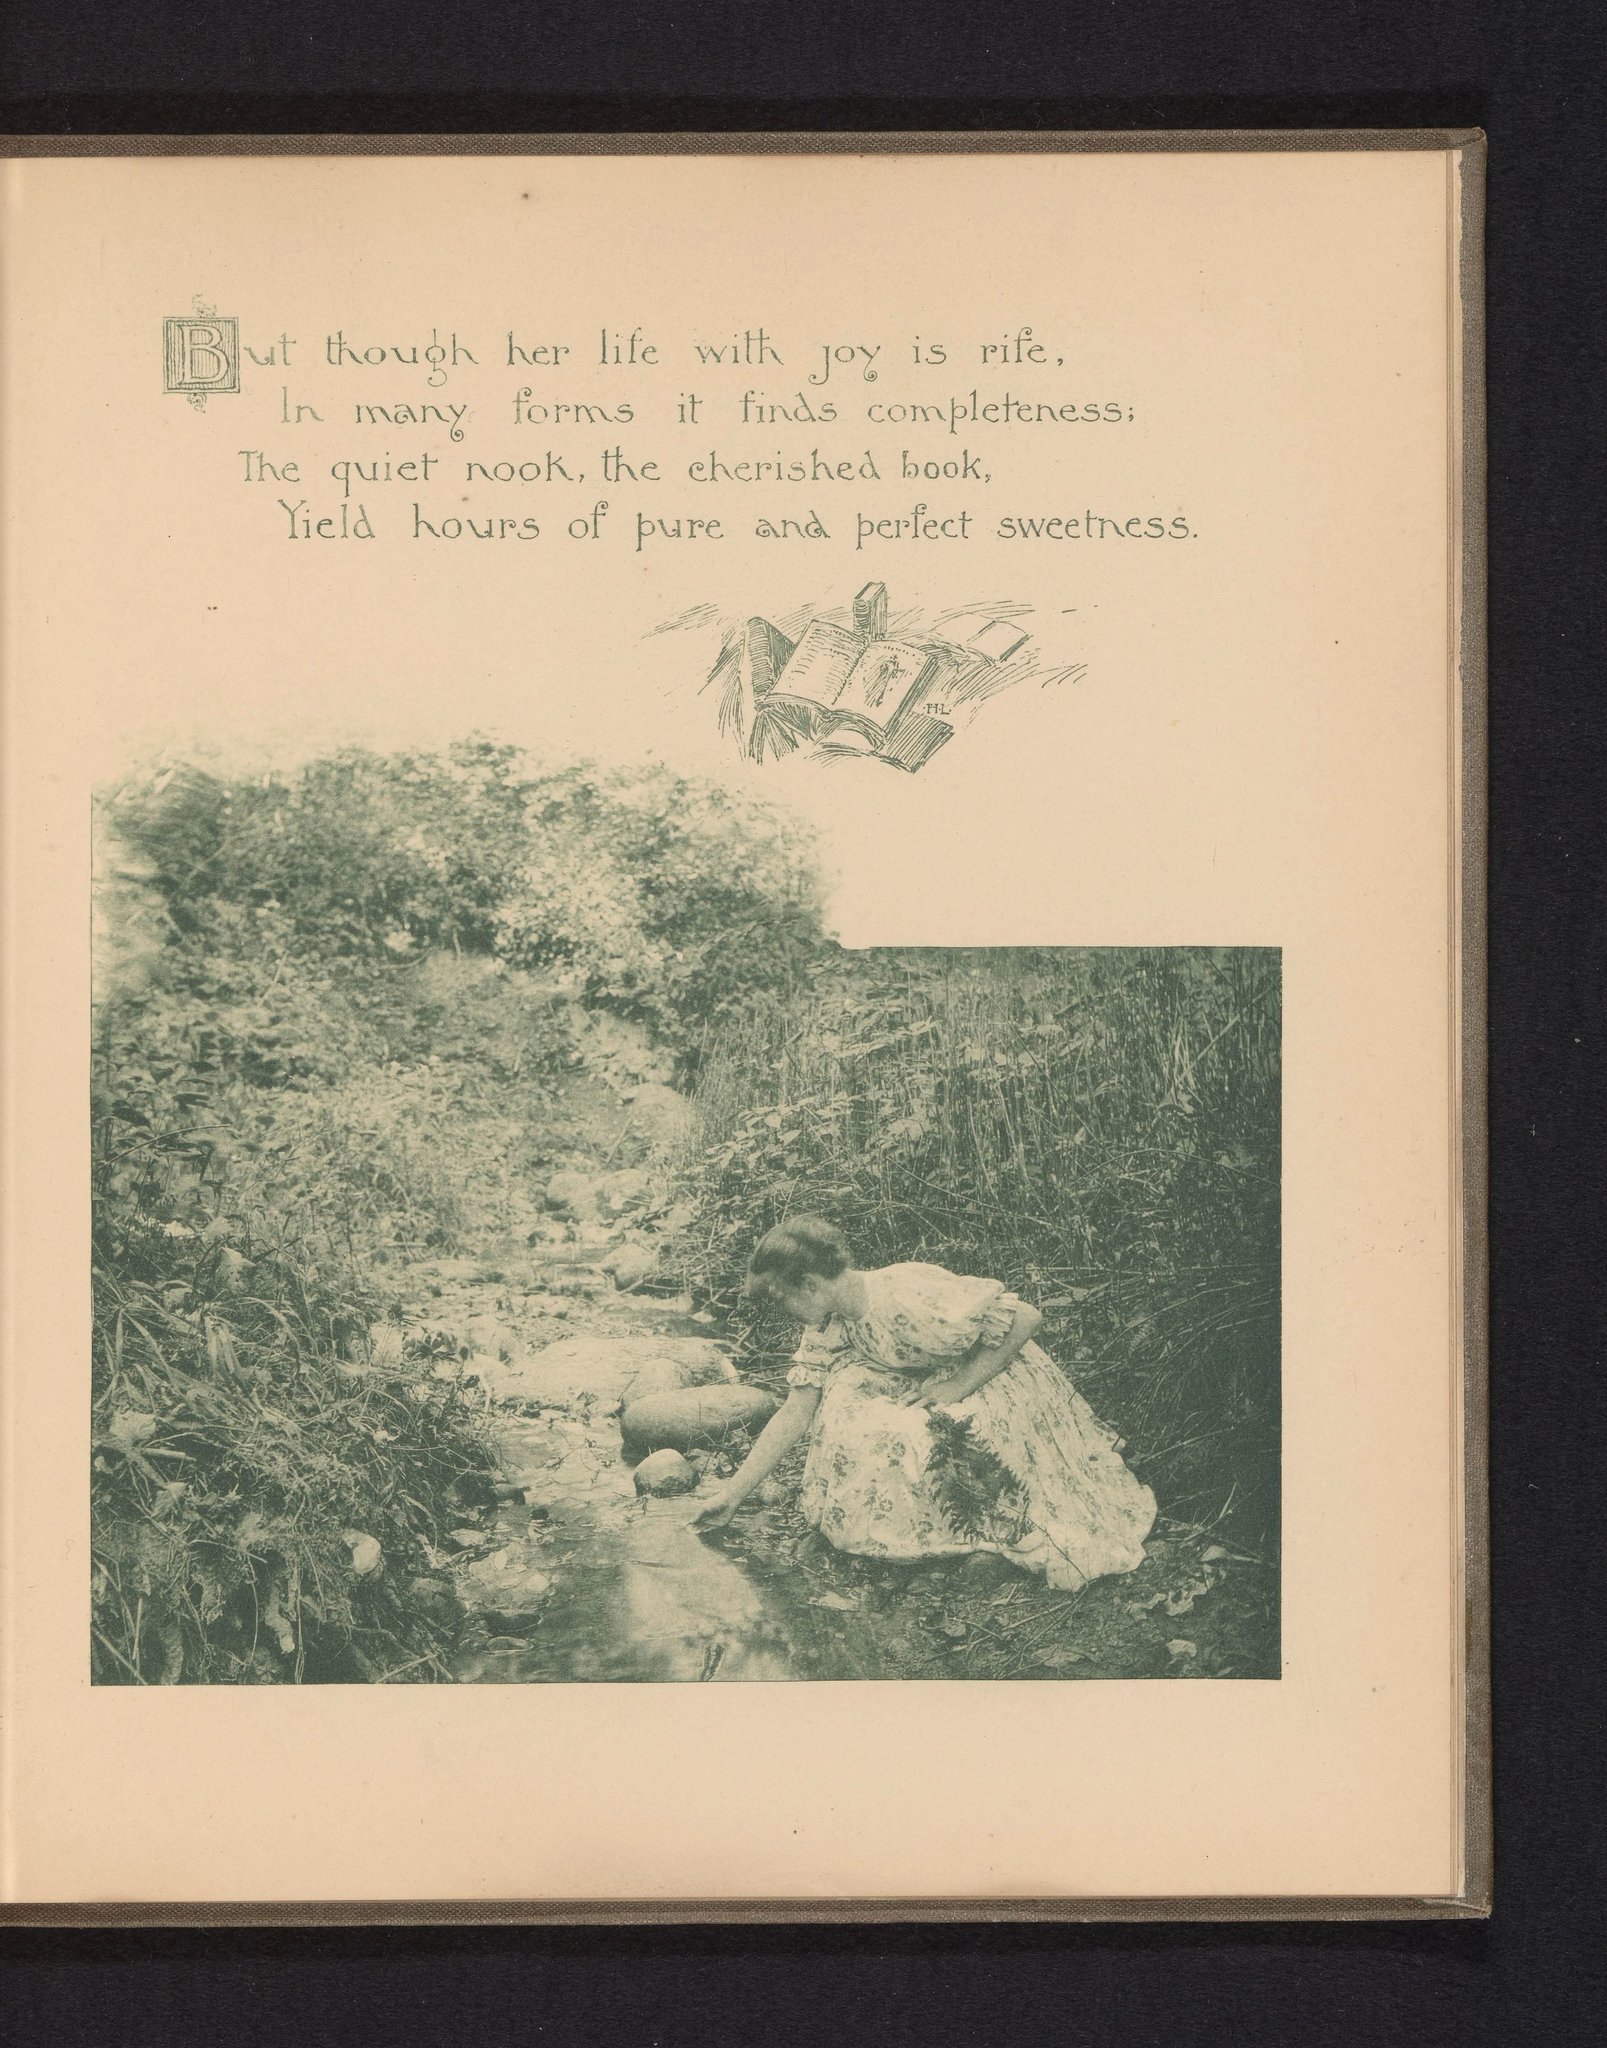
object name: page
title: Vrouw gehurkt bij een beek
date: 1884-1894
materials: paper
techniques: photoaquatint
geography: united states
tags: adolescent, young woman, maiden, brook